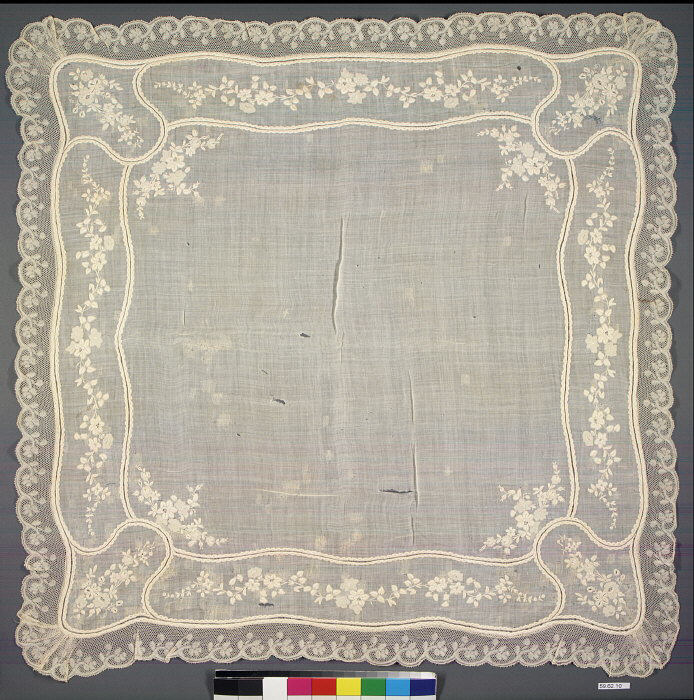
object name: handkerchief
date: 1801-1900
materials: cotton, linen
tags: flowers